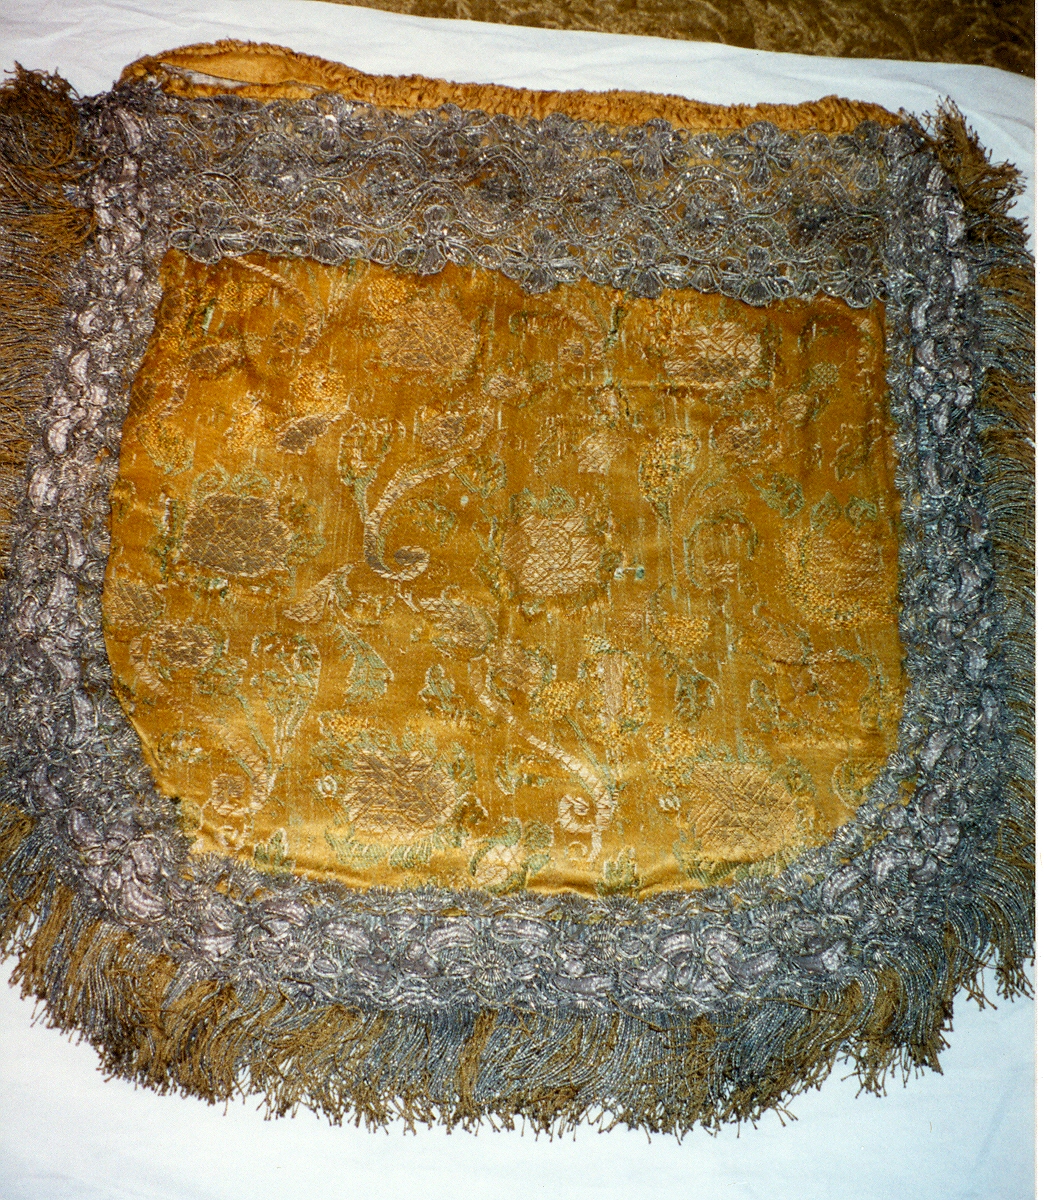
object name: hood from a cope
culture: french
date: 1701-1800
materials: metal, silk